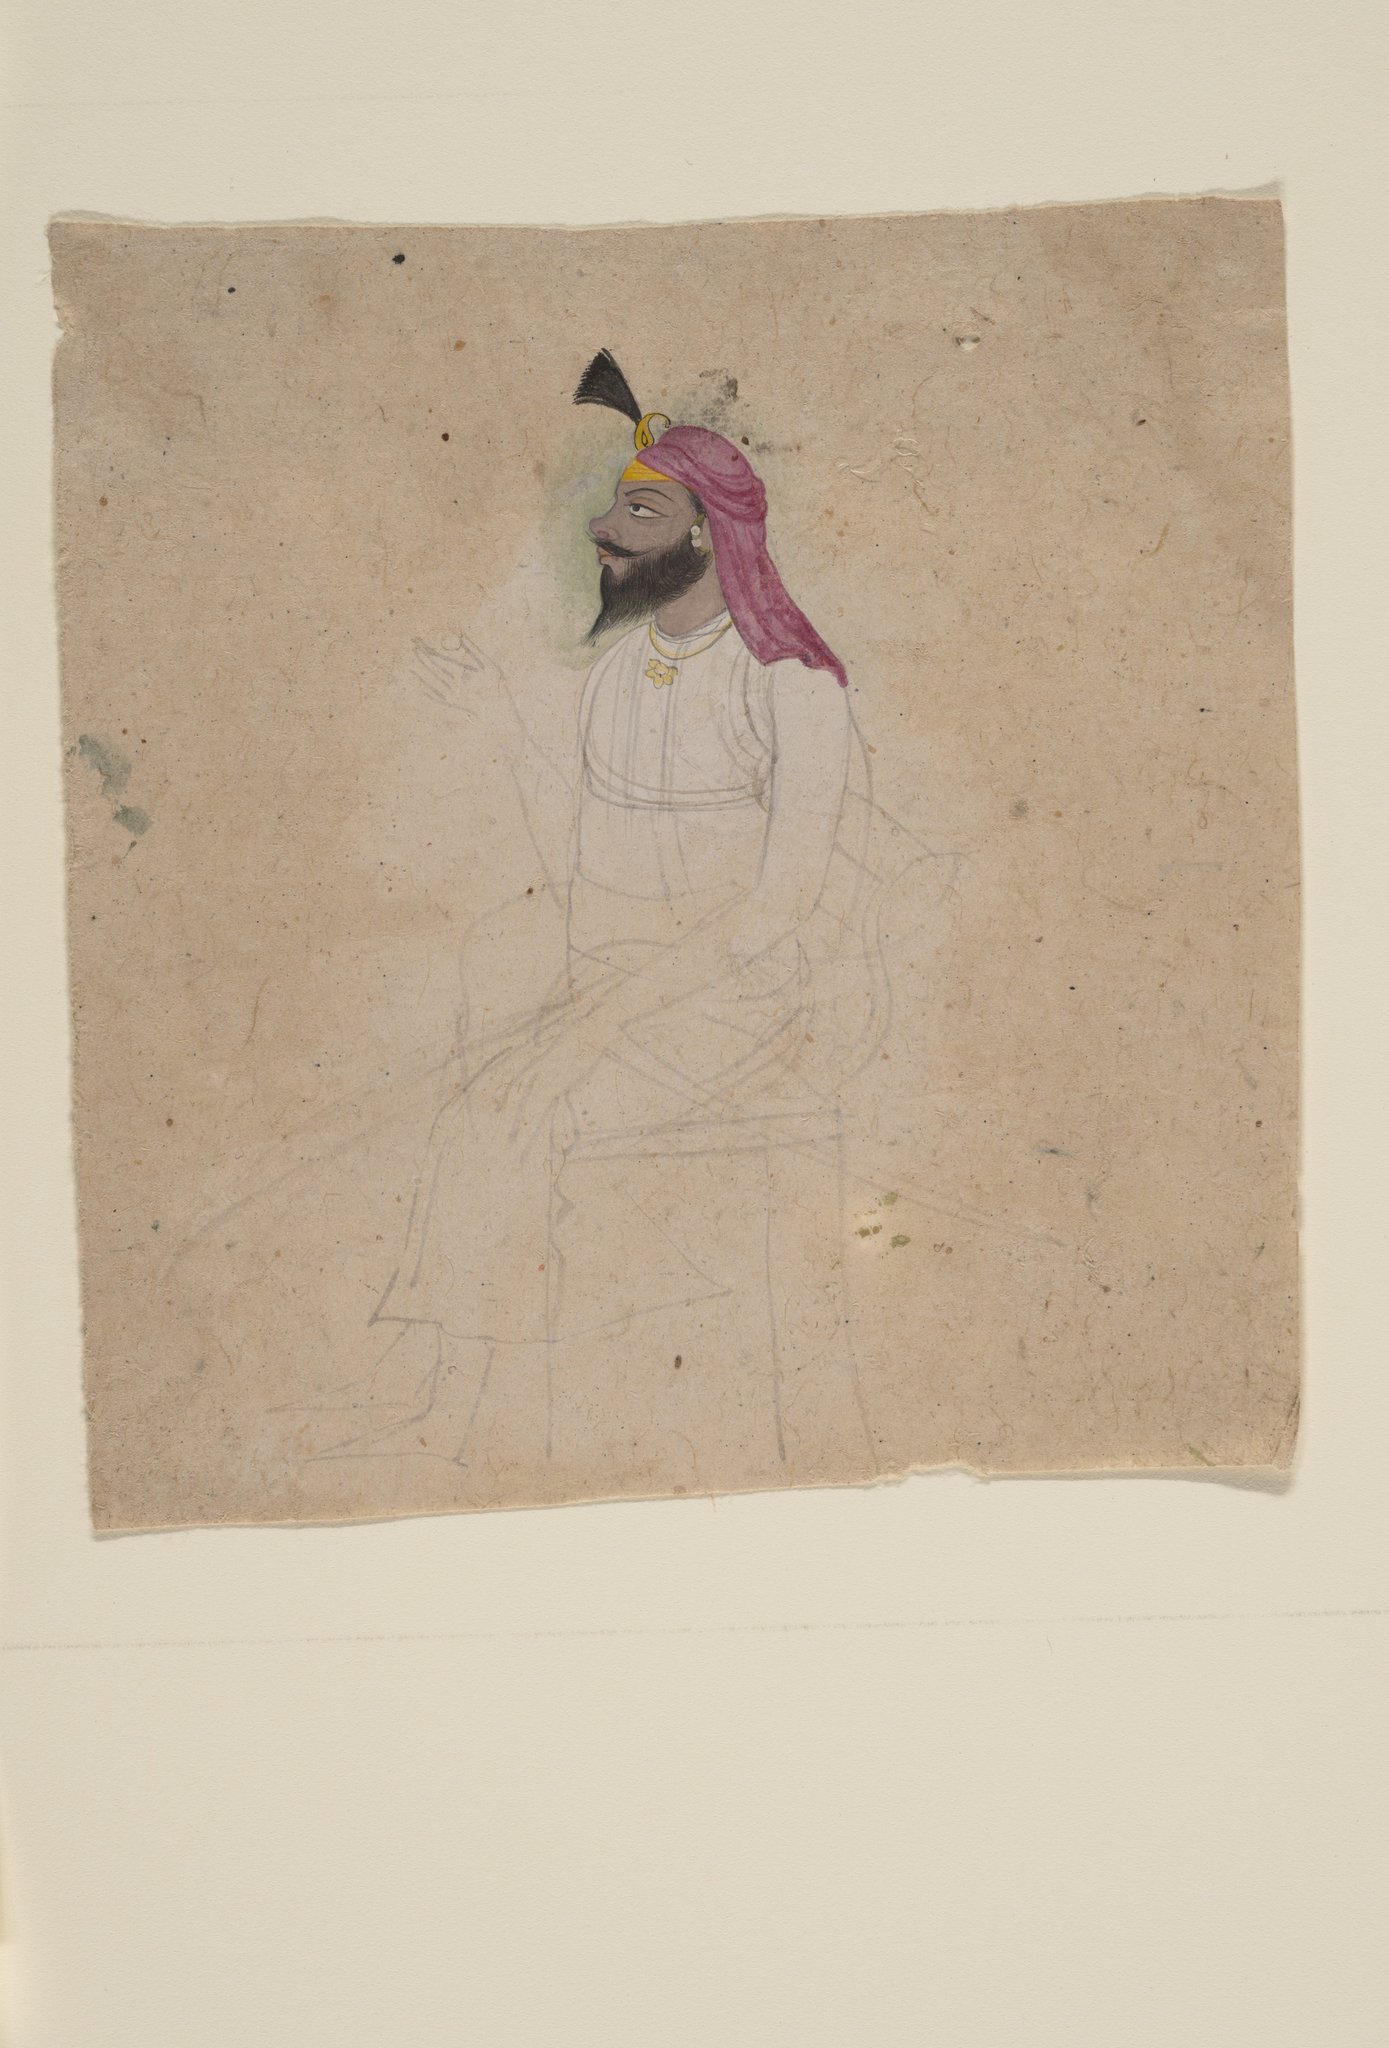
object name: painting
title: Portrait of a Sikh Noble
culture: indian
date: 1801-1833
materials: ink, paper, watercolor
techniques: wash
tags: men,portraits